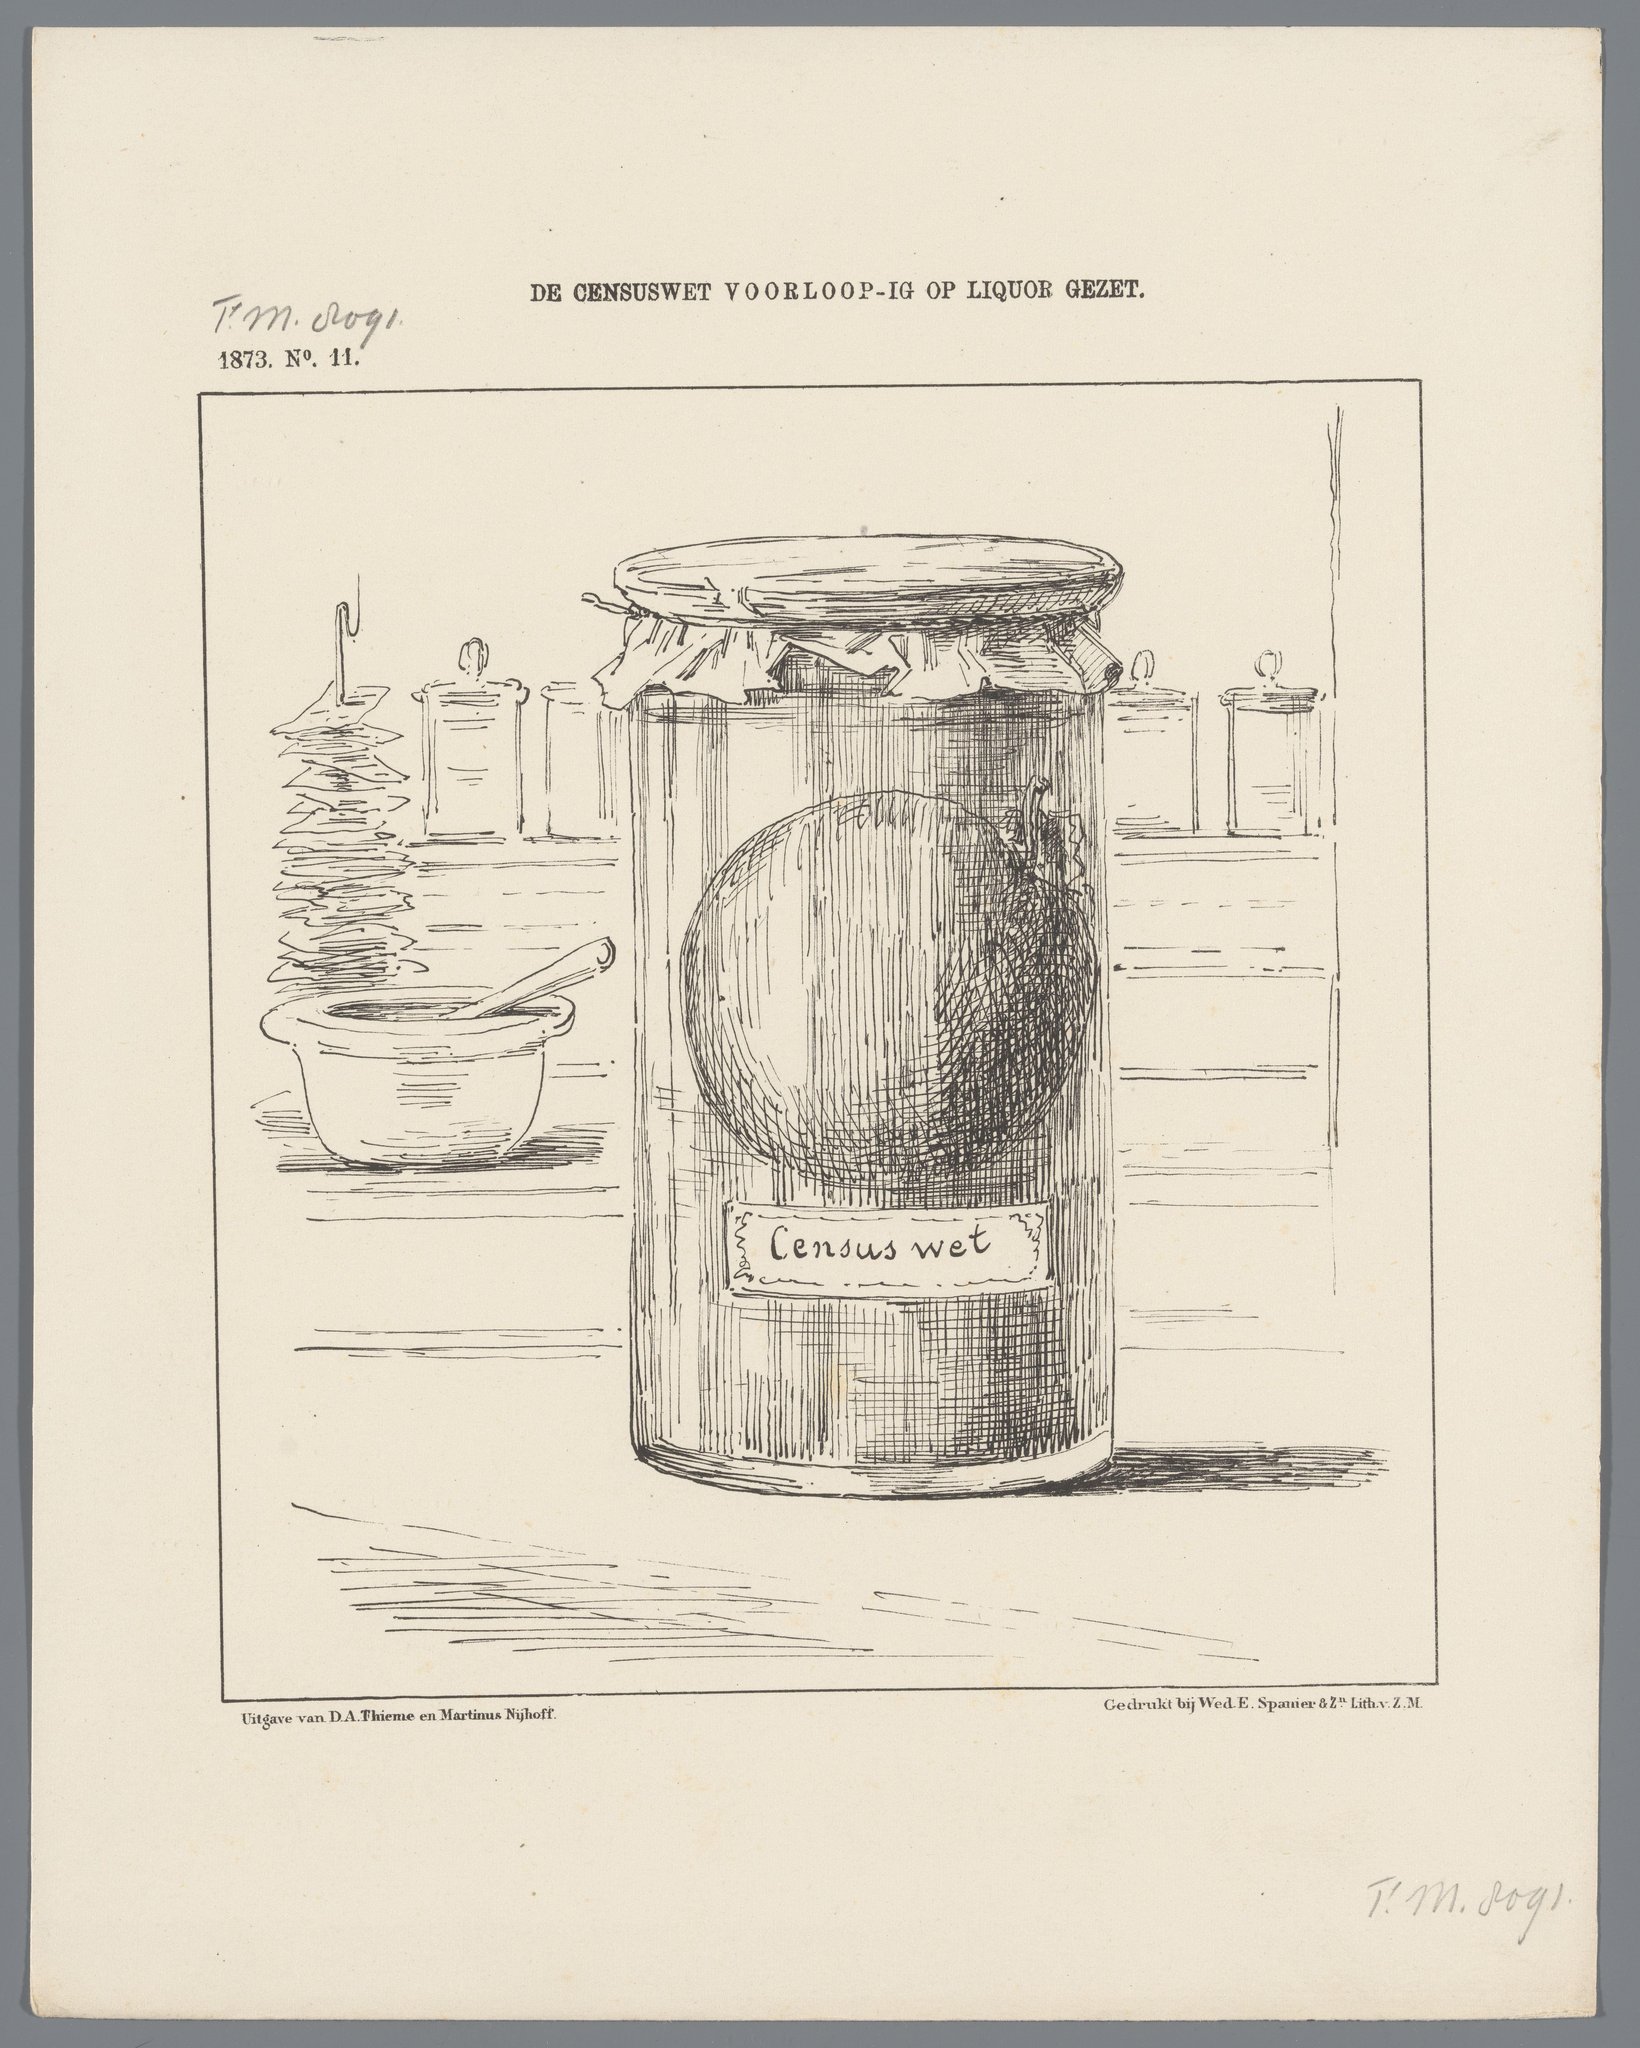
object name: print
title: Spotprent over de censuswet, 1873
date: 1873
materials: paper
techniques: lithograph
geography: netherlands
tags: anatomical specimen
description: Spotprent waarin de ongeboren censuswet op sterk water is gezet. Plaat verschenen bij het weekblad De Nederlandsche Spectator, nr. 11, 1873.